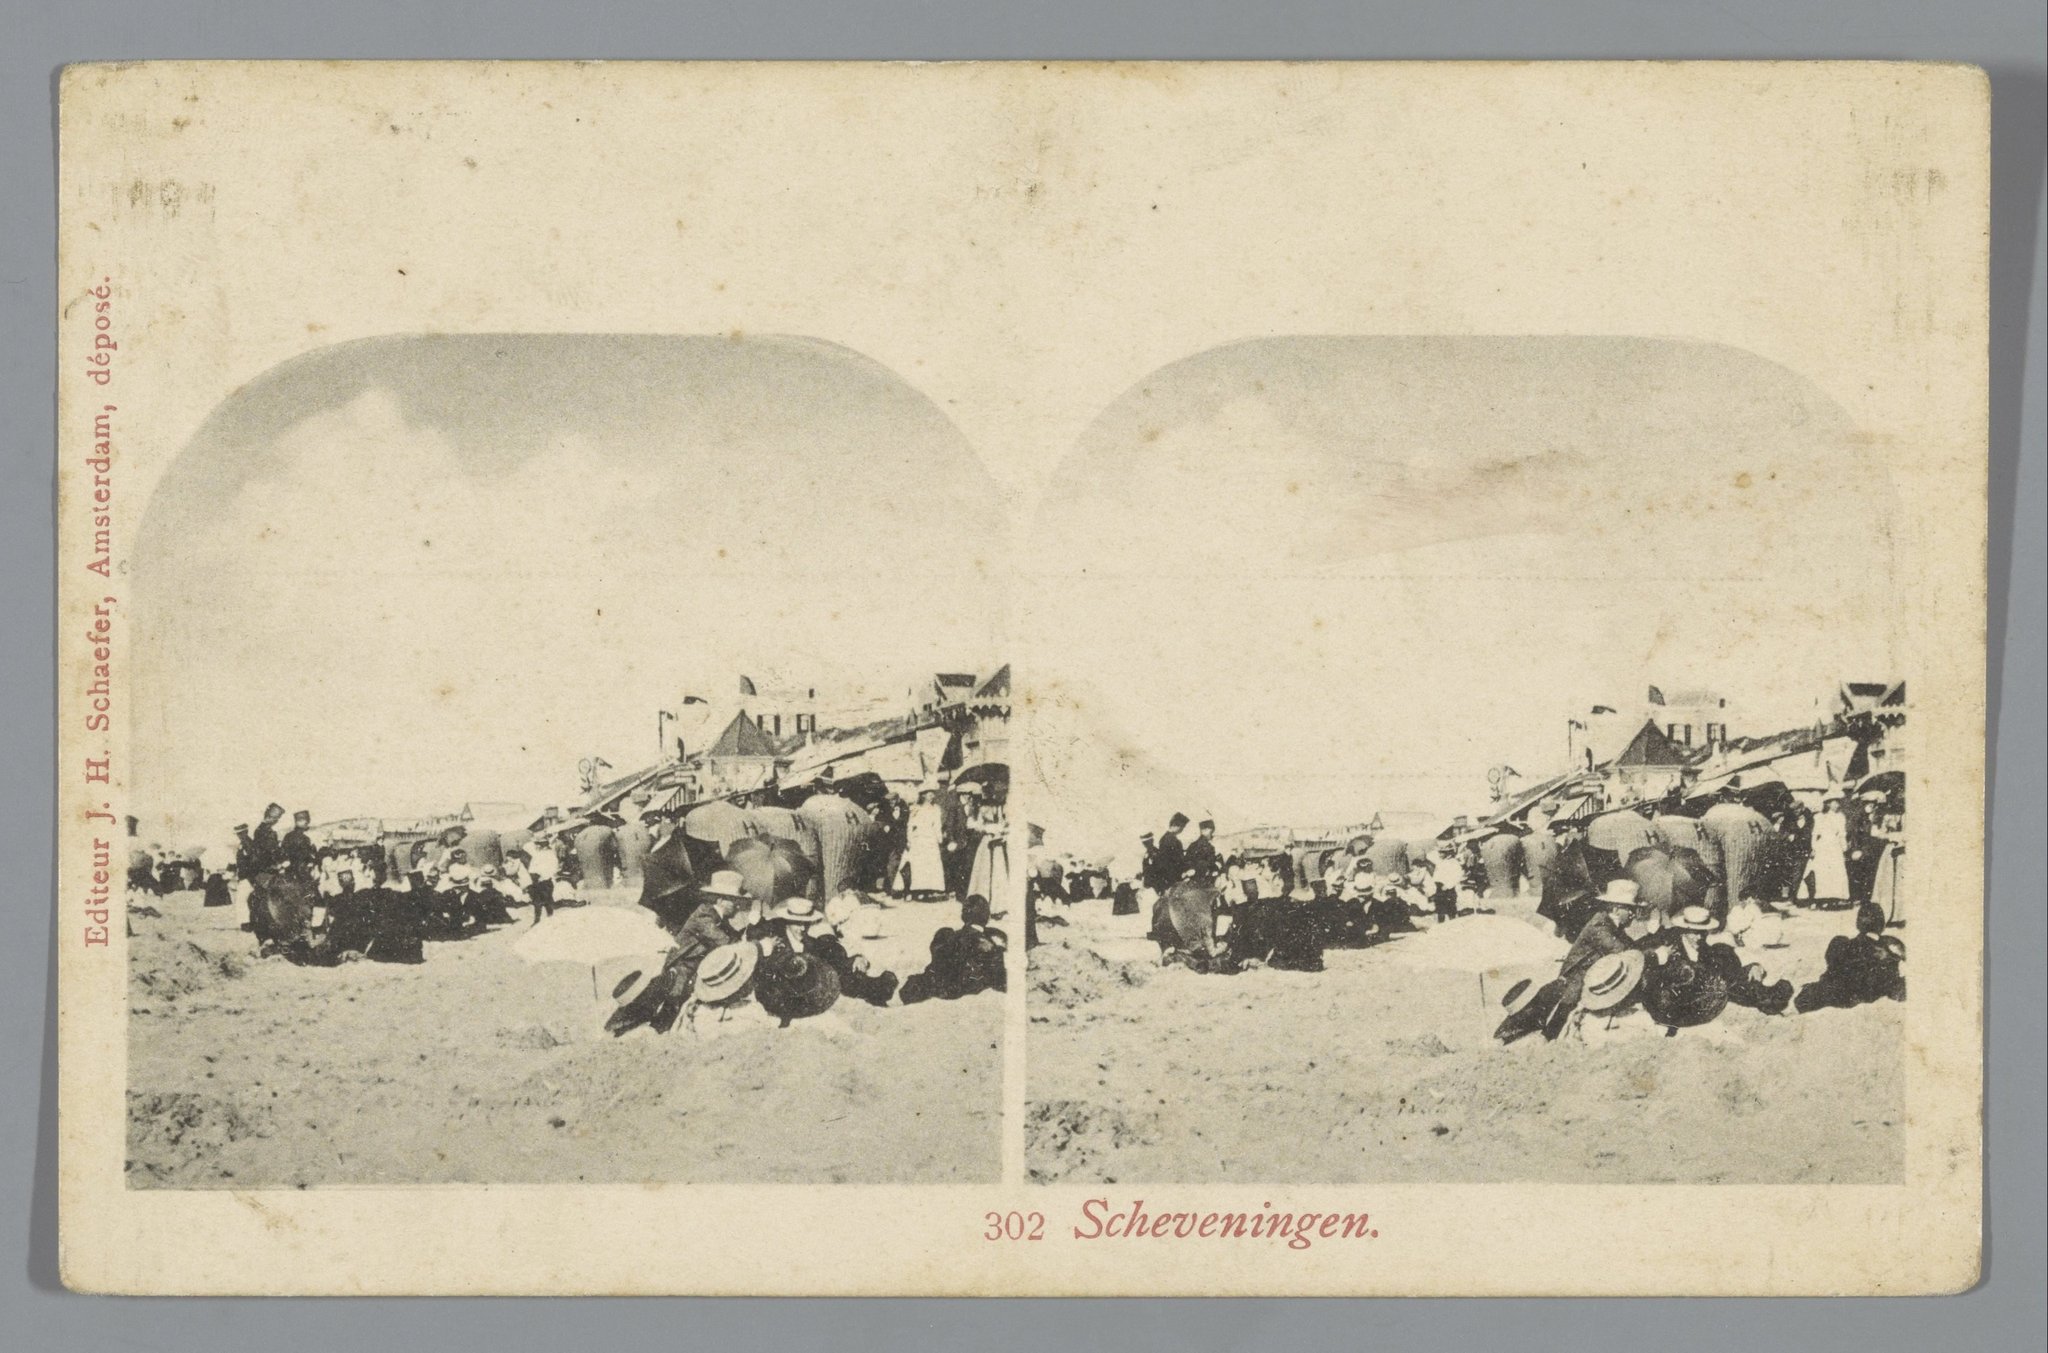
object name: ansichtkaart, prentbriefkaart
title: Mensen op het strand van Scheveningen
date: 1896-1905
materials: cardboard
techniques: photograph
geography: scheveningen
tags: beach (as place of recreation)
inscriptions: inscription: ‘Briefkaart/ Aan...’, number: ‘302’, number: ‘1,-’